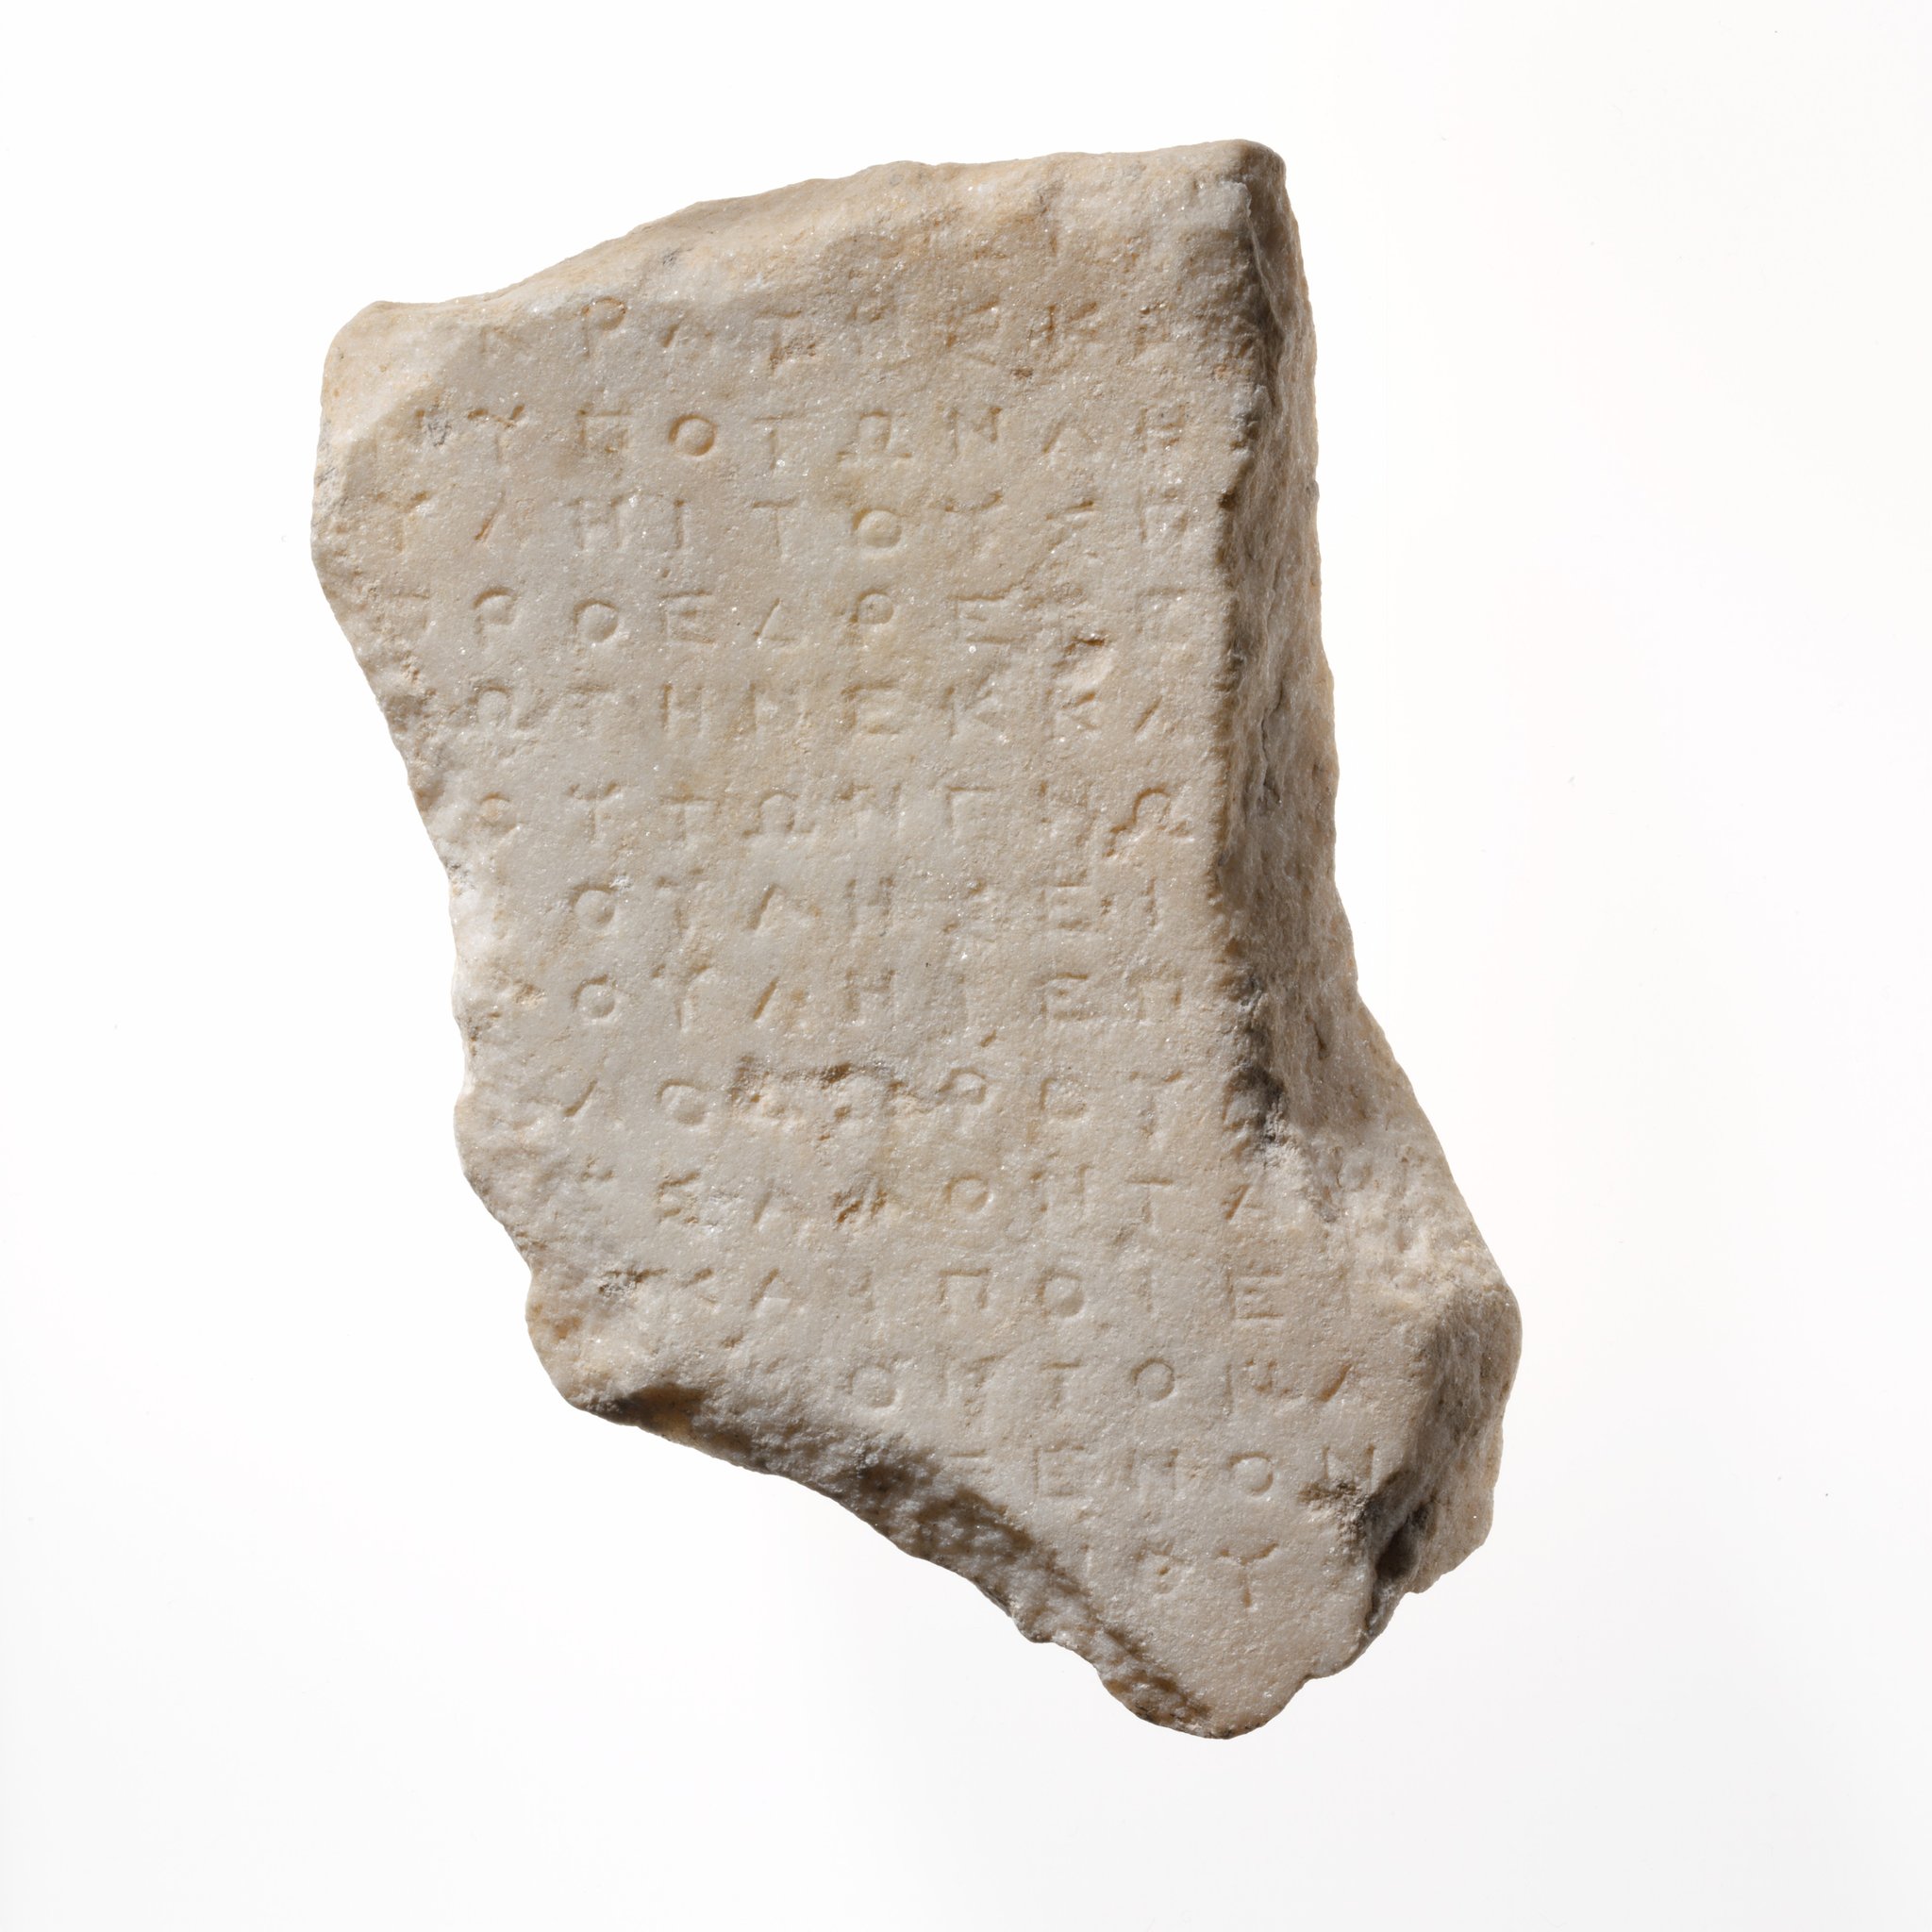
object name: inscription, athenian decree fragment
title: Fragmentary marble inscription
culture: greek, attic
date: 350-301 BCE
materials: marble